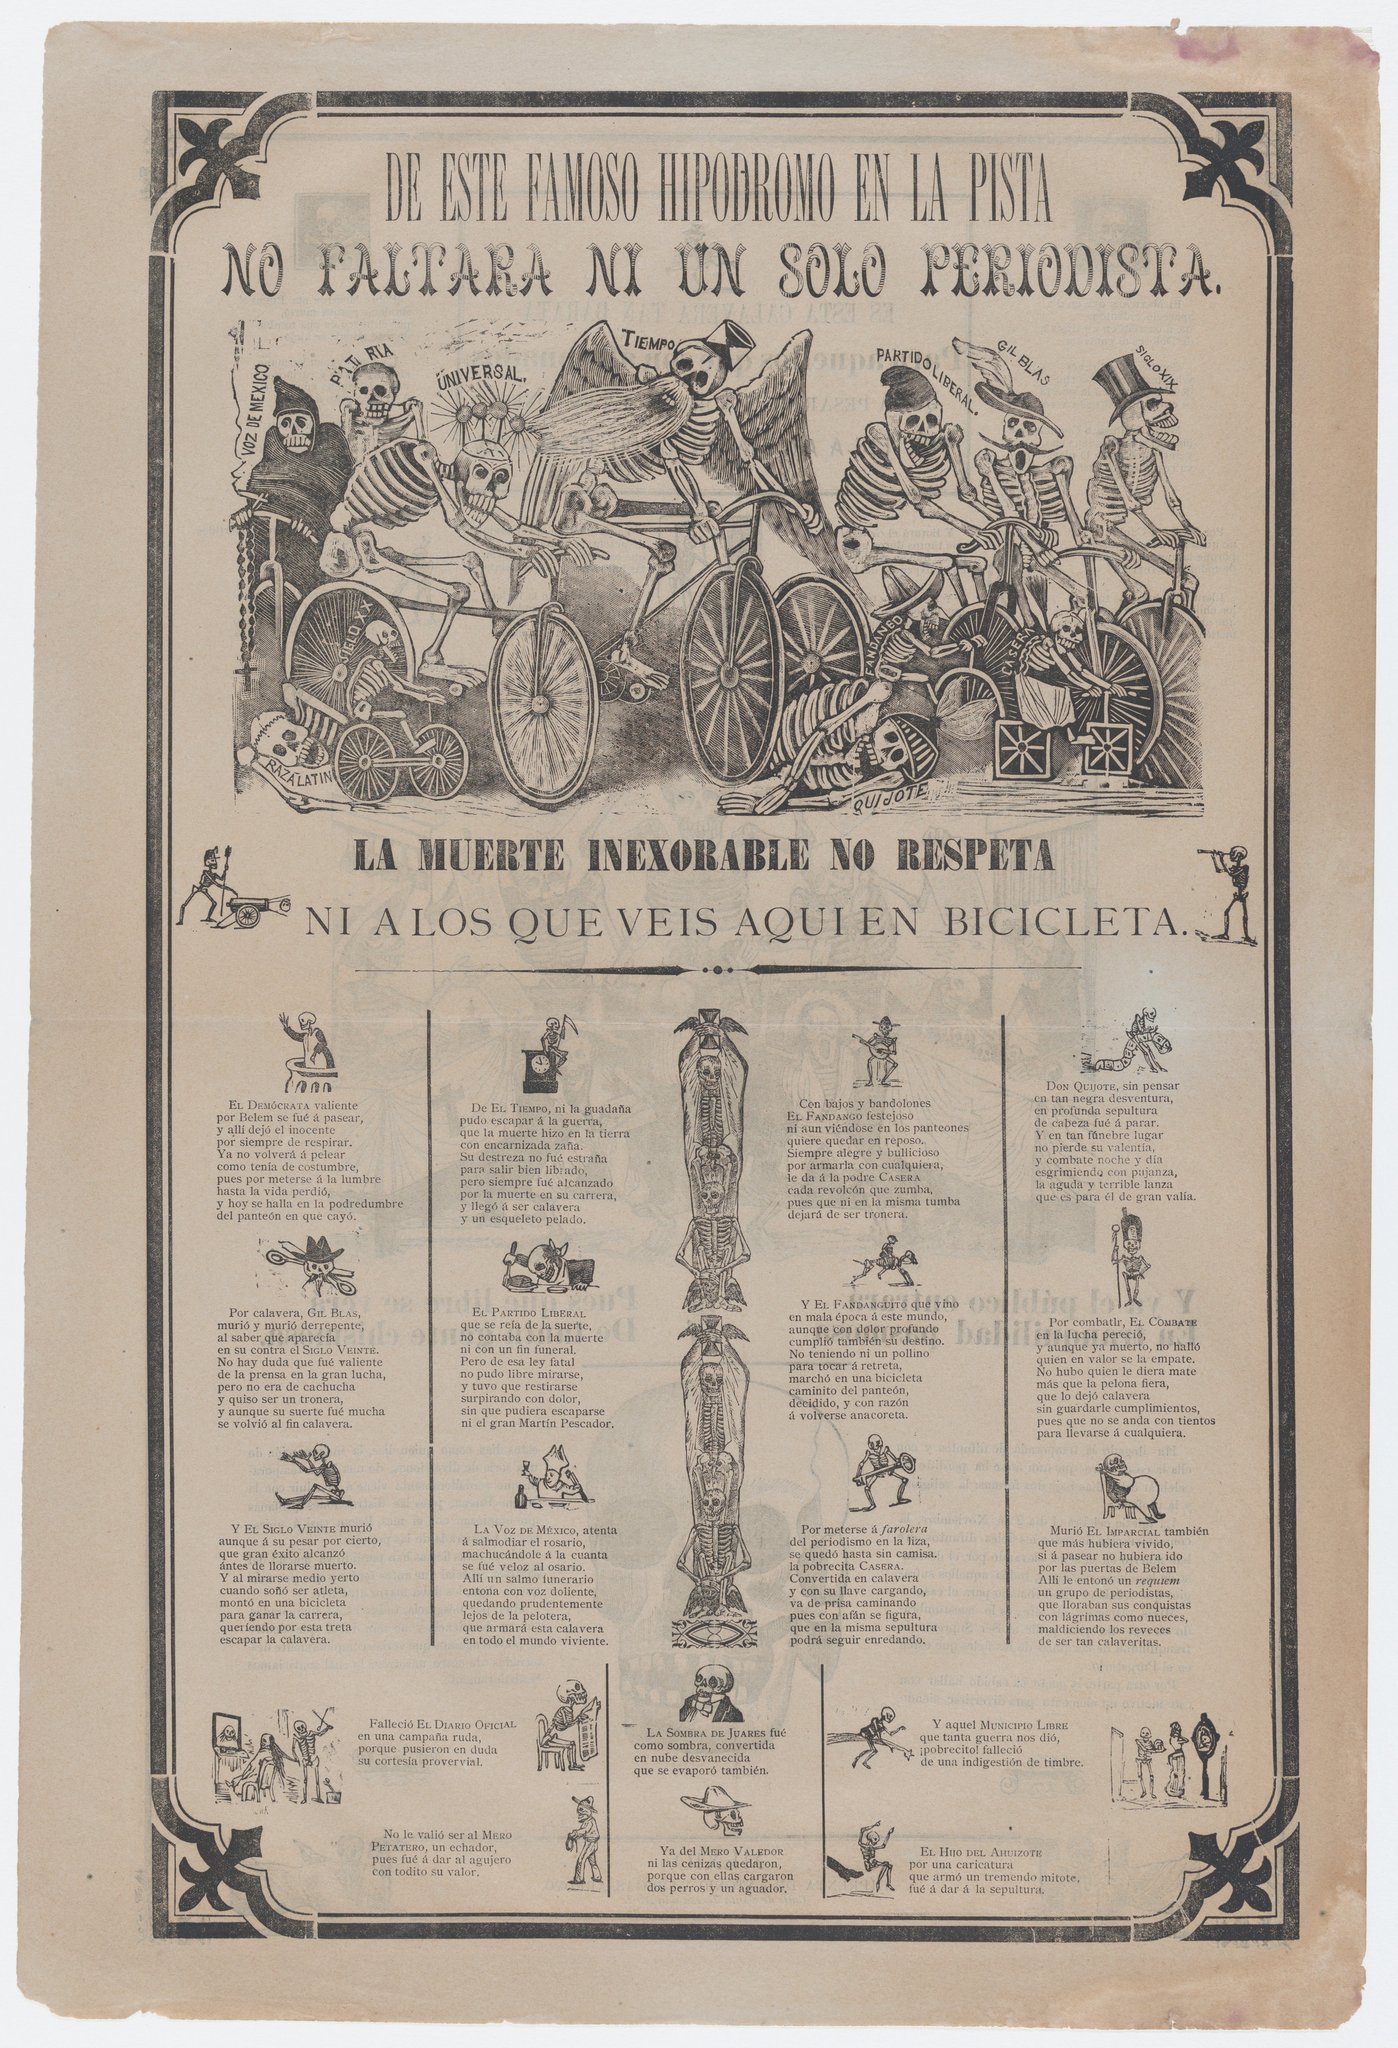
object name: print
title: Broadside: on recto skeletons riding bicycles; on verso skeletons buying and selling printed images etc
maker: josé guadalupe posada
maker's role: artist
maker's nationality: mexican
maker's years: 1852-1913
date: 1895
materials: metal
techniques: engraving, letterpress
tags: skeletons,bicycles